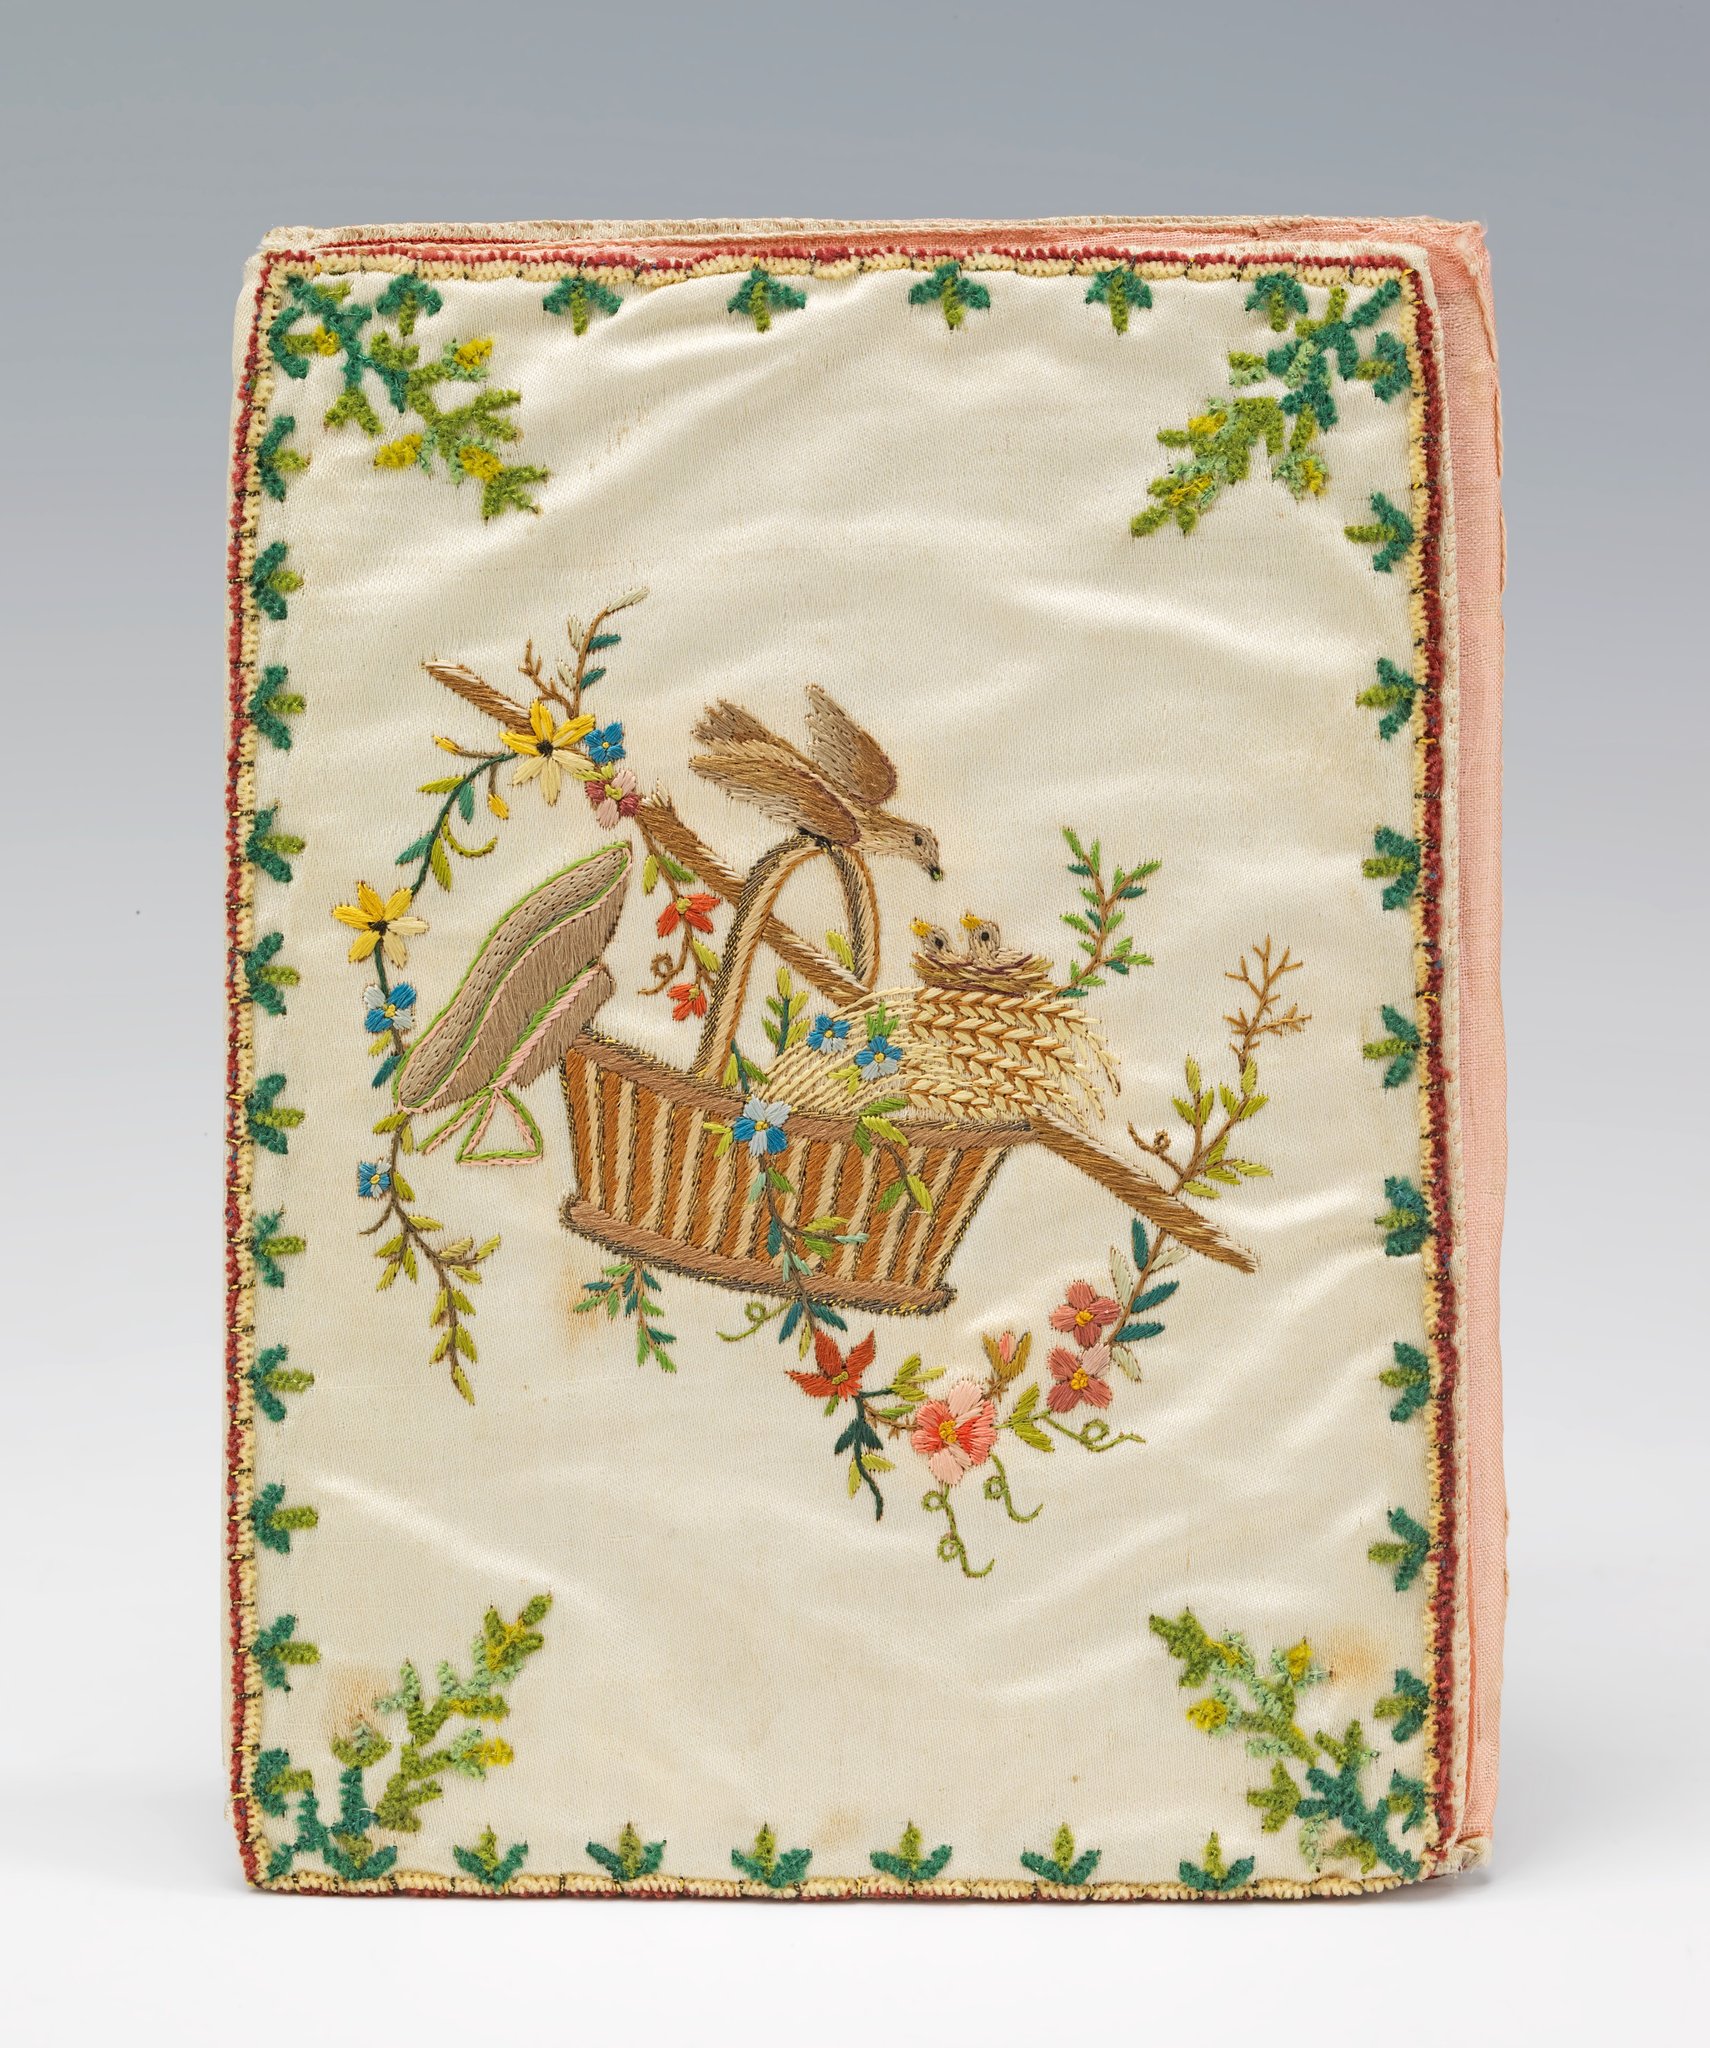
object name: case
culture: european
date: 1800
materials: silk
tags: birds,baskets